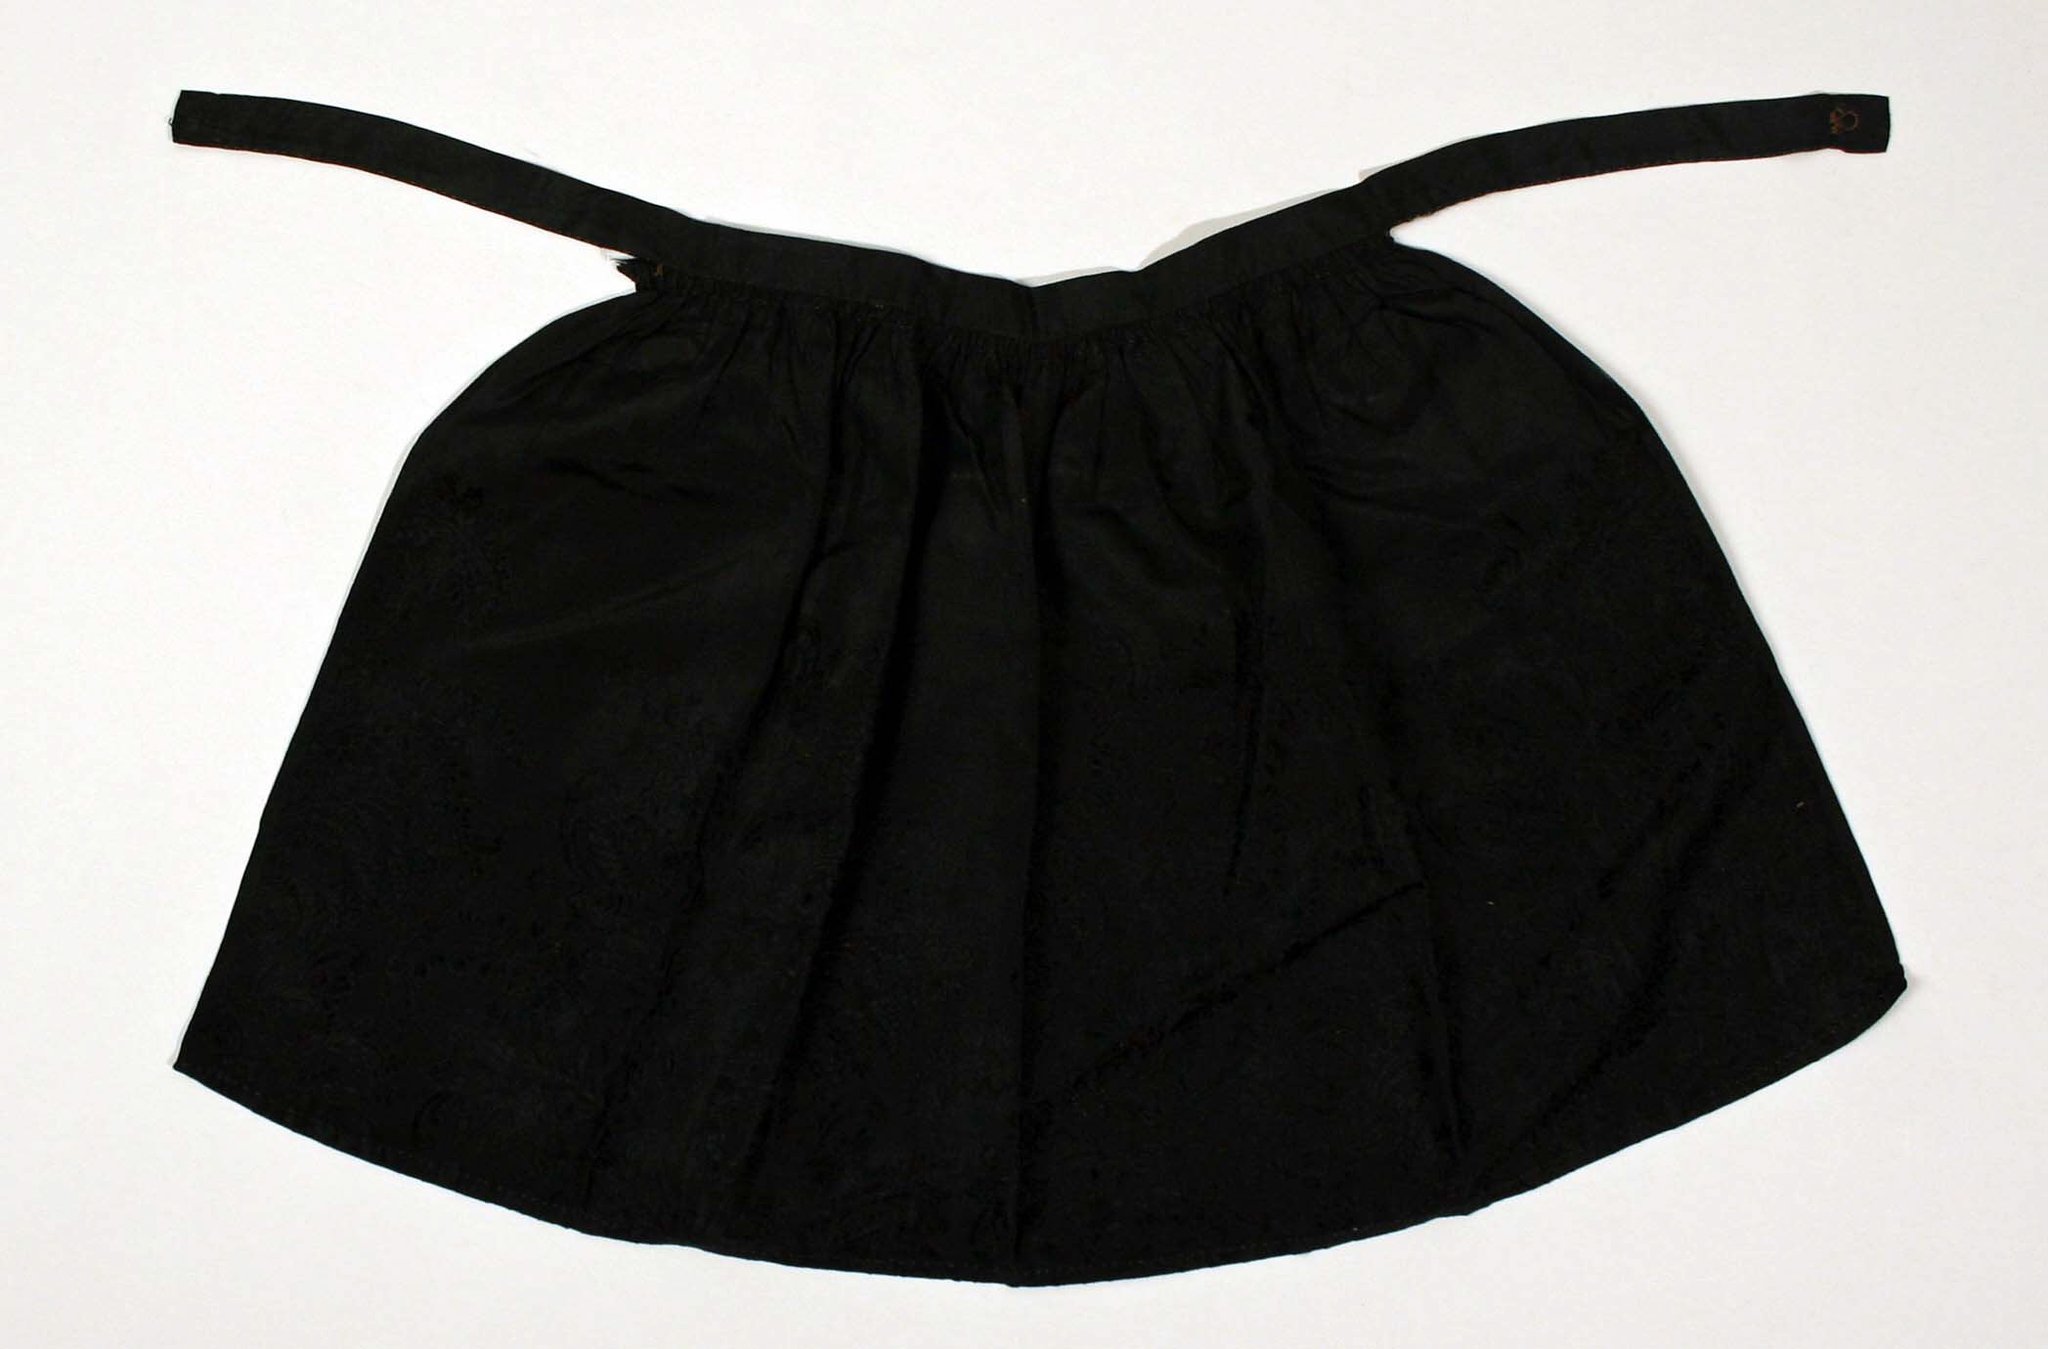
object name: apron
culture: american or european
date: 1866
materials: silk